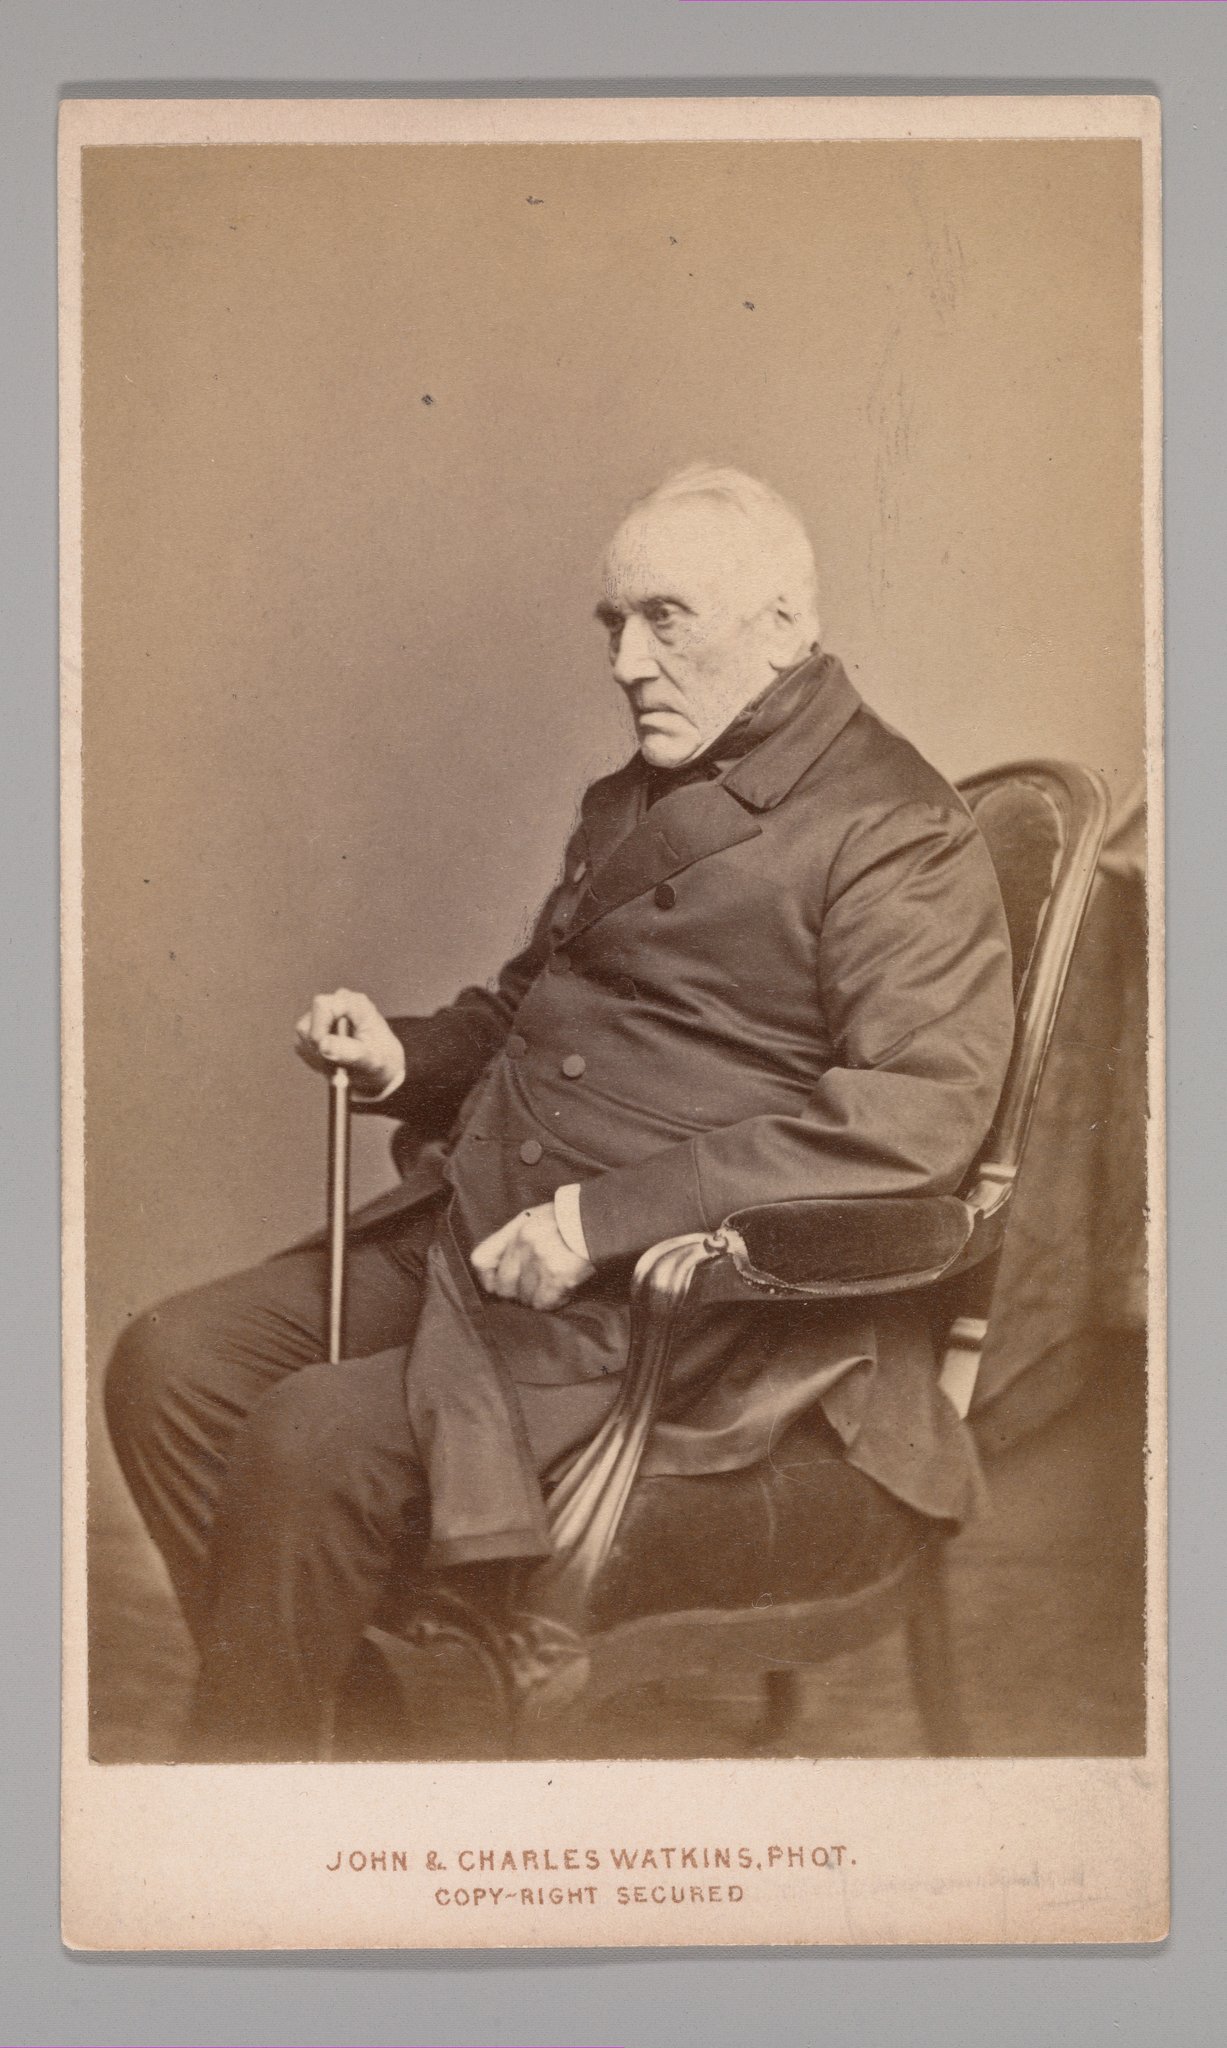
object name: carte de visite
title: [Unknown Subject]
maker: john and charles watkins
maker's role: photography studio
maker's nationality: british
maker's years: 1840-1875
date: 1860-1869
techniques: albumen silver print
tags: men,portraits,profiles